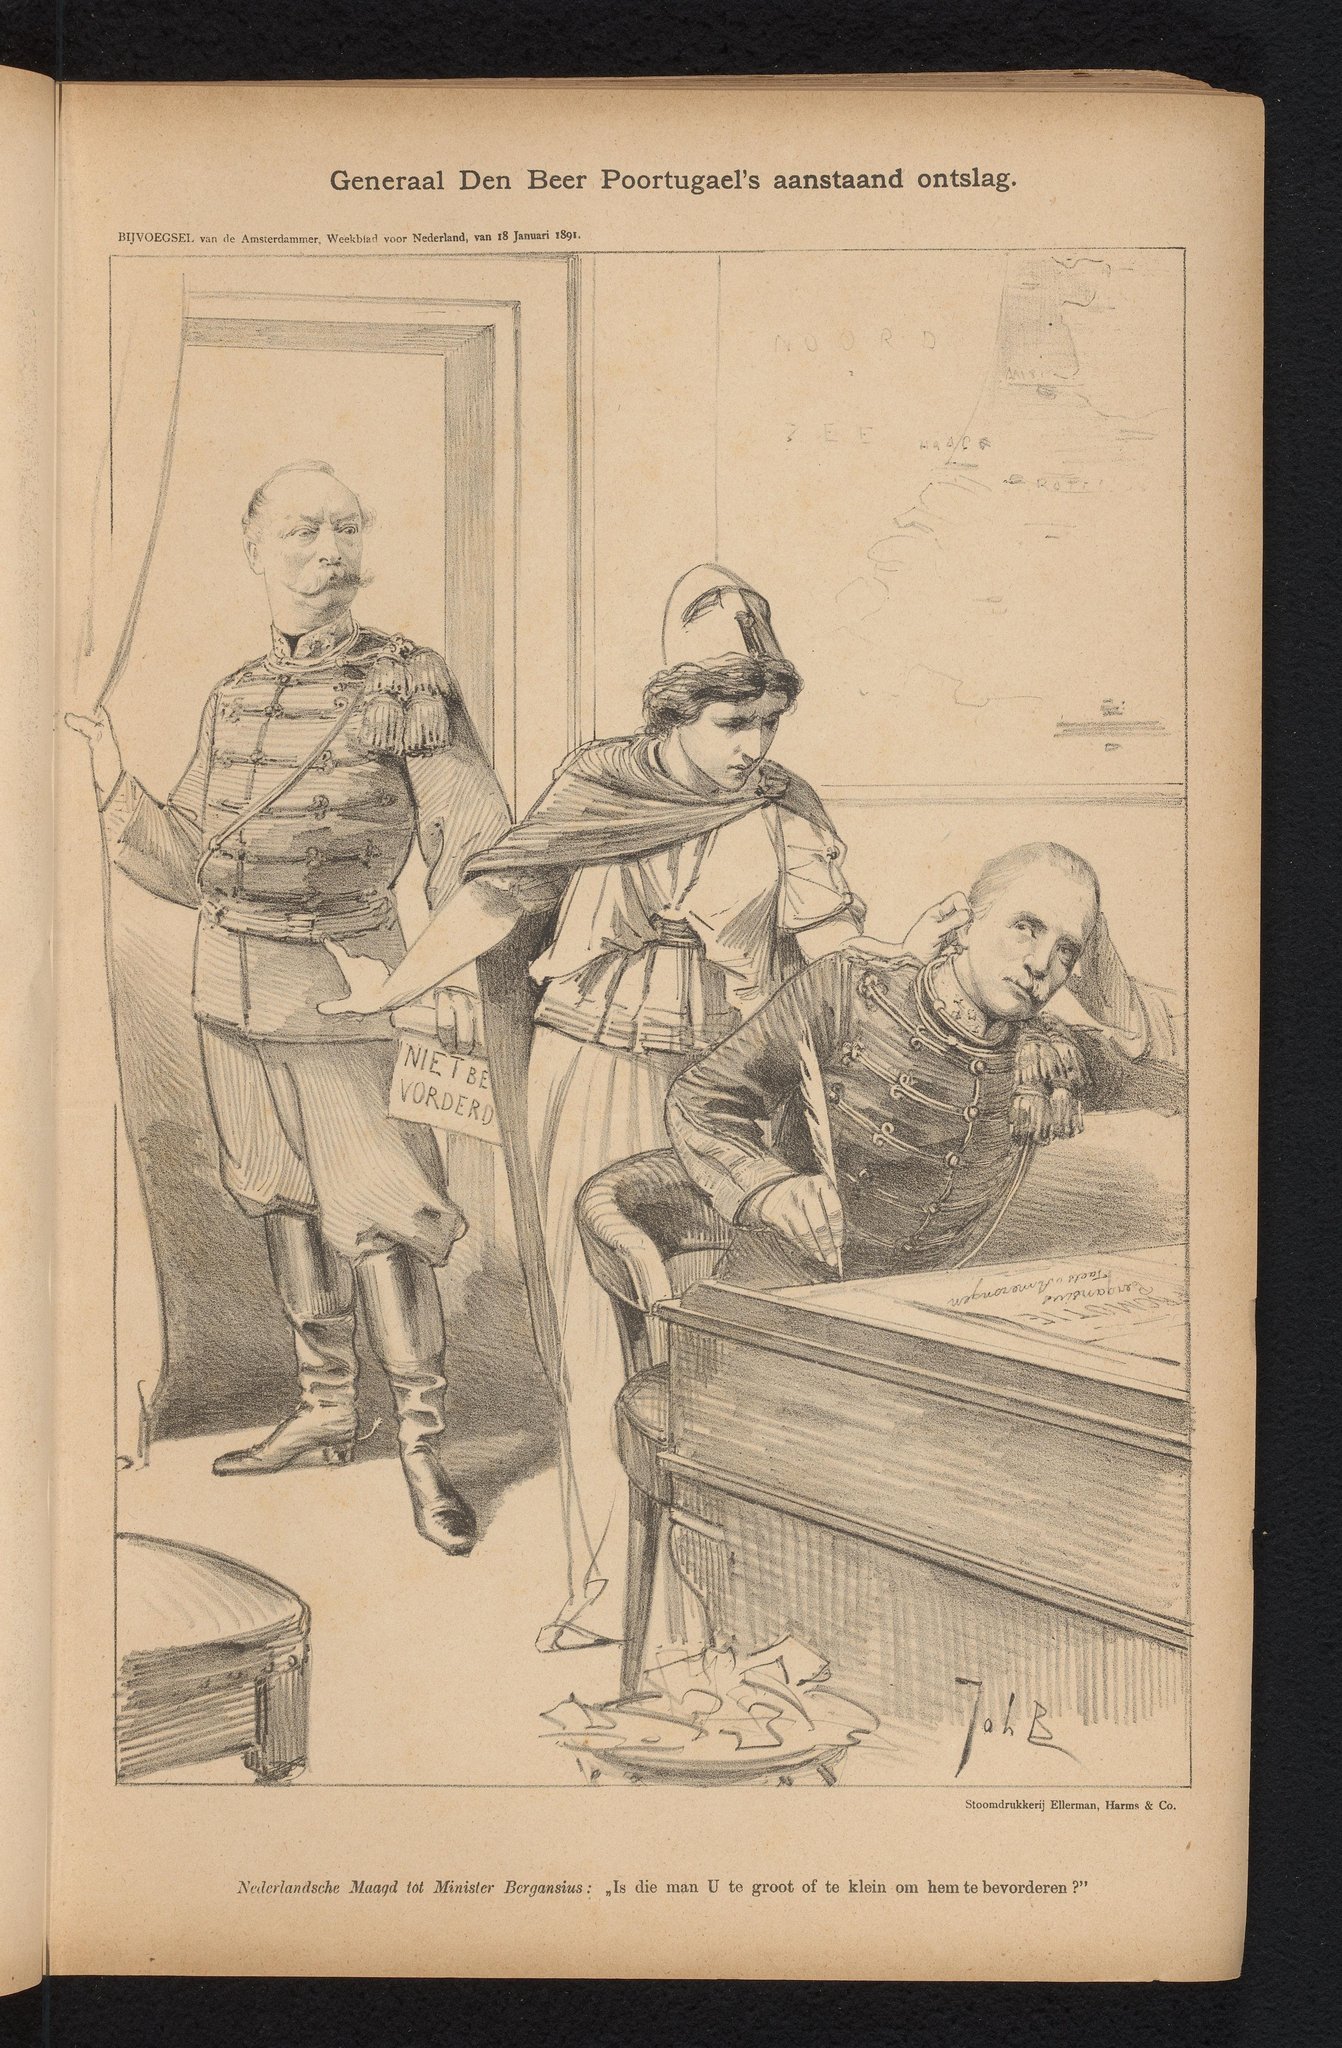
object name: cartoon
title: Generaal Den Beer Poortugael's aanstaand ontslag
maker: johan braakensiek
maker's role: draughtsman, print maker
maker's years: 1858-1940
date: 1891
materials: paper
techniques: lithograph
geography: amsterdam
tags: delft, leiden, the hague, personifications of countries, nations, states, districts, etc. (+ nation; national), political caricatures and satires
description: De Nederlandse Maagd geeft minister van Oorlog Berganius een draai om de oren omdat hij generaal J.C.C. den Beer Poortugael niet heeft bevorderd.